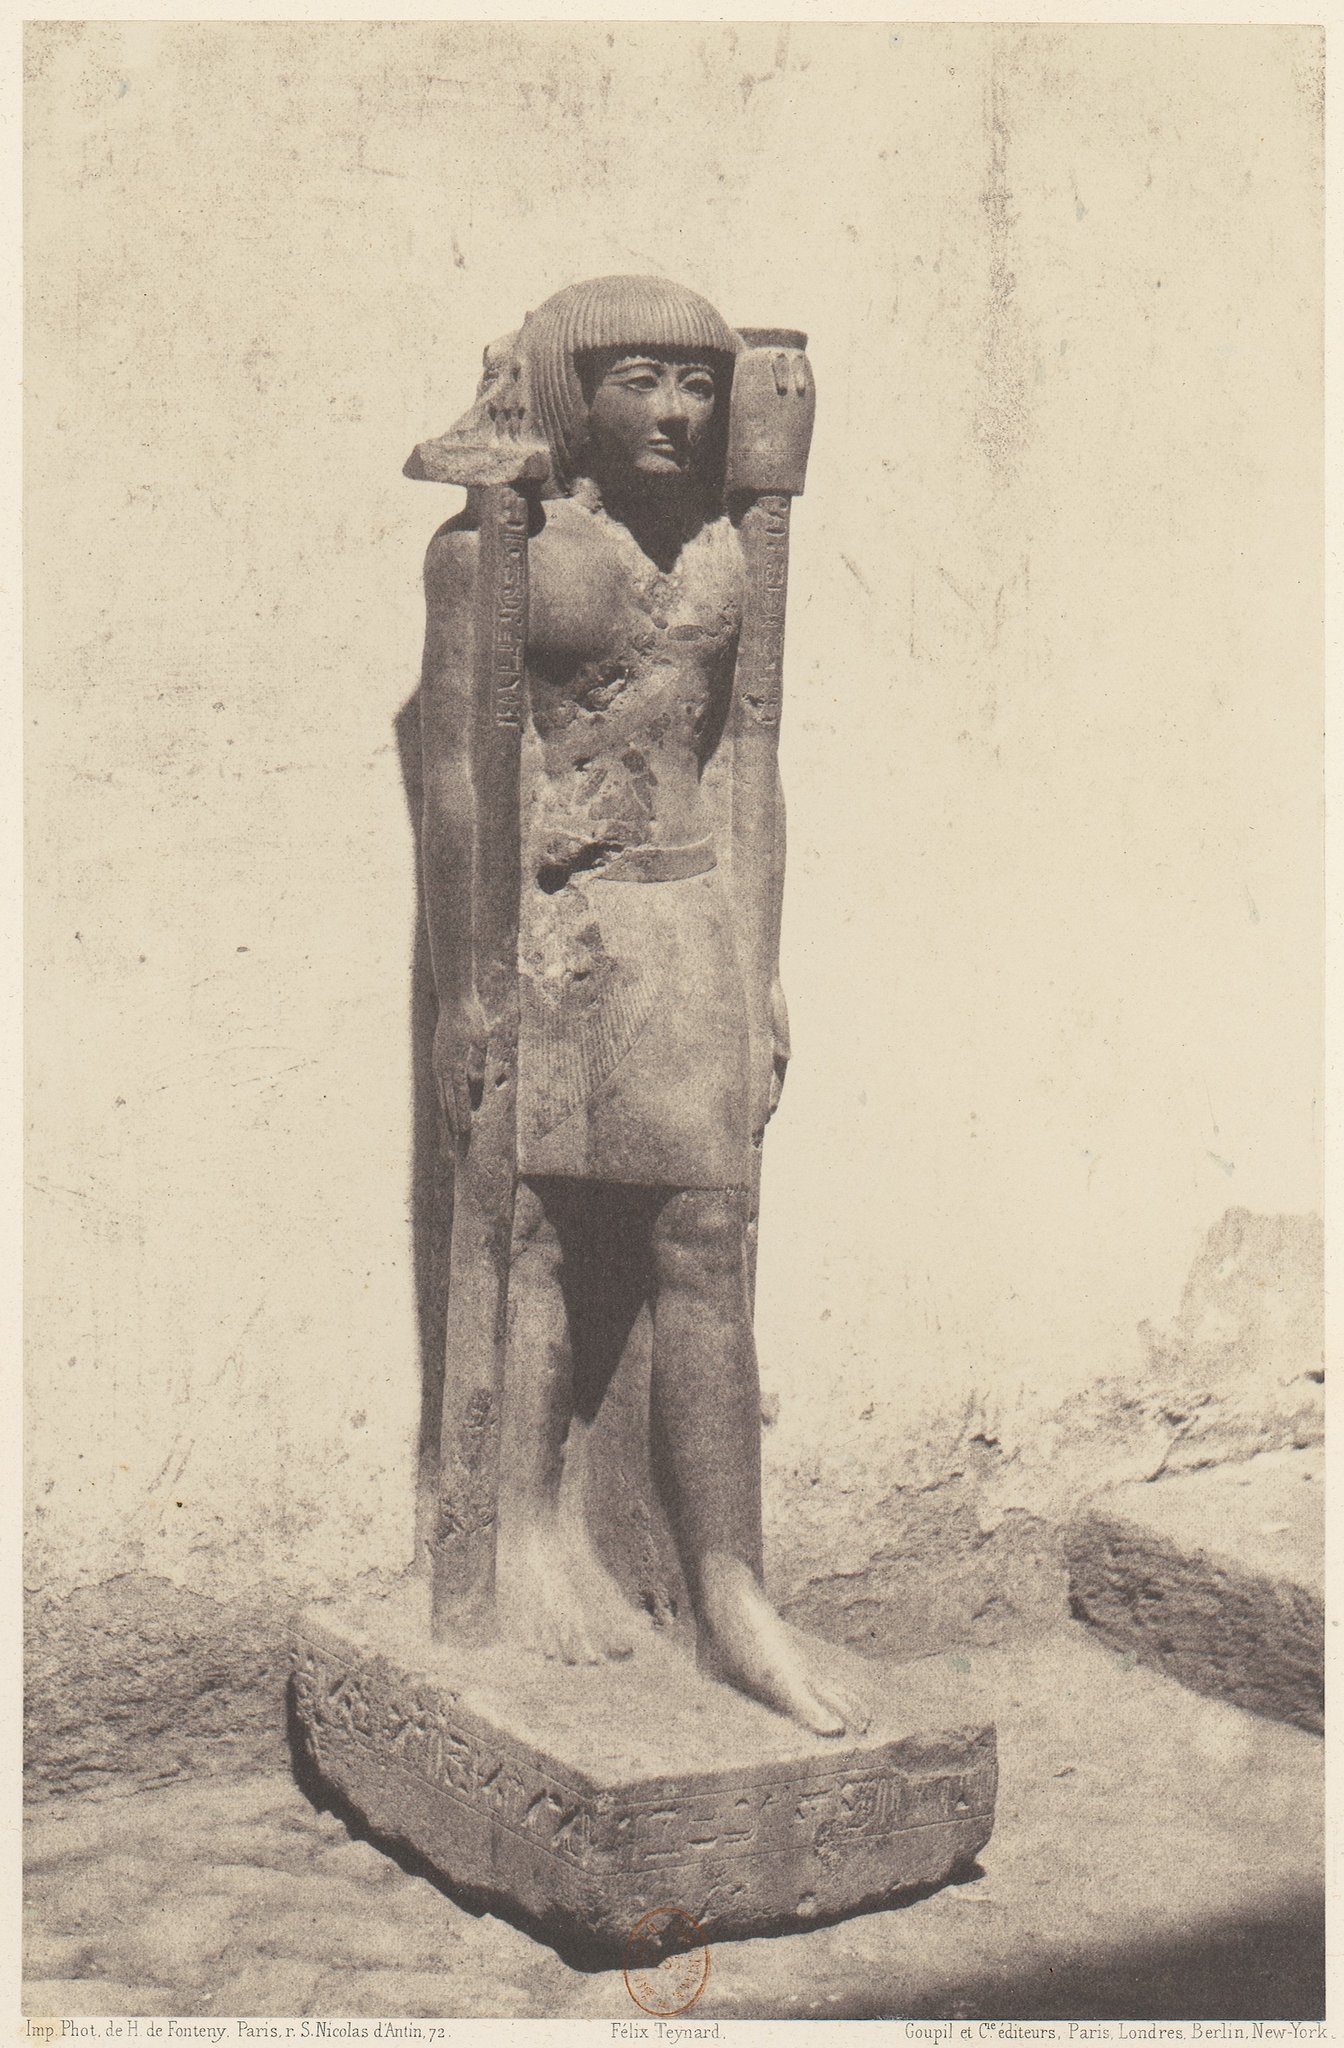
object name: photograph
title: Syout (Lycopolis), Statue Appartenant au Docteaur Cuny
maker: félix teynard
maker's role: artist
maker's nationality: french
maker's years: 1817-1892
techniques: paper negative, salted paper print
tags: sculpture